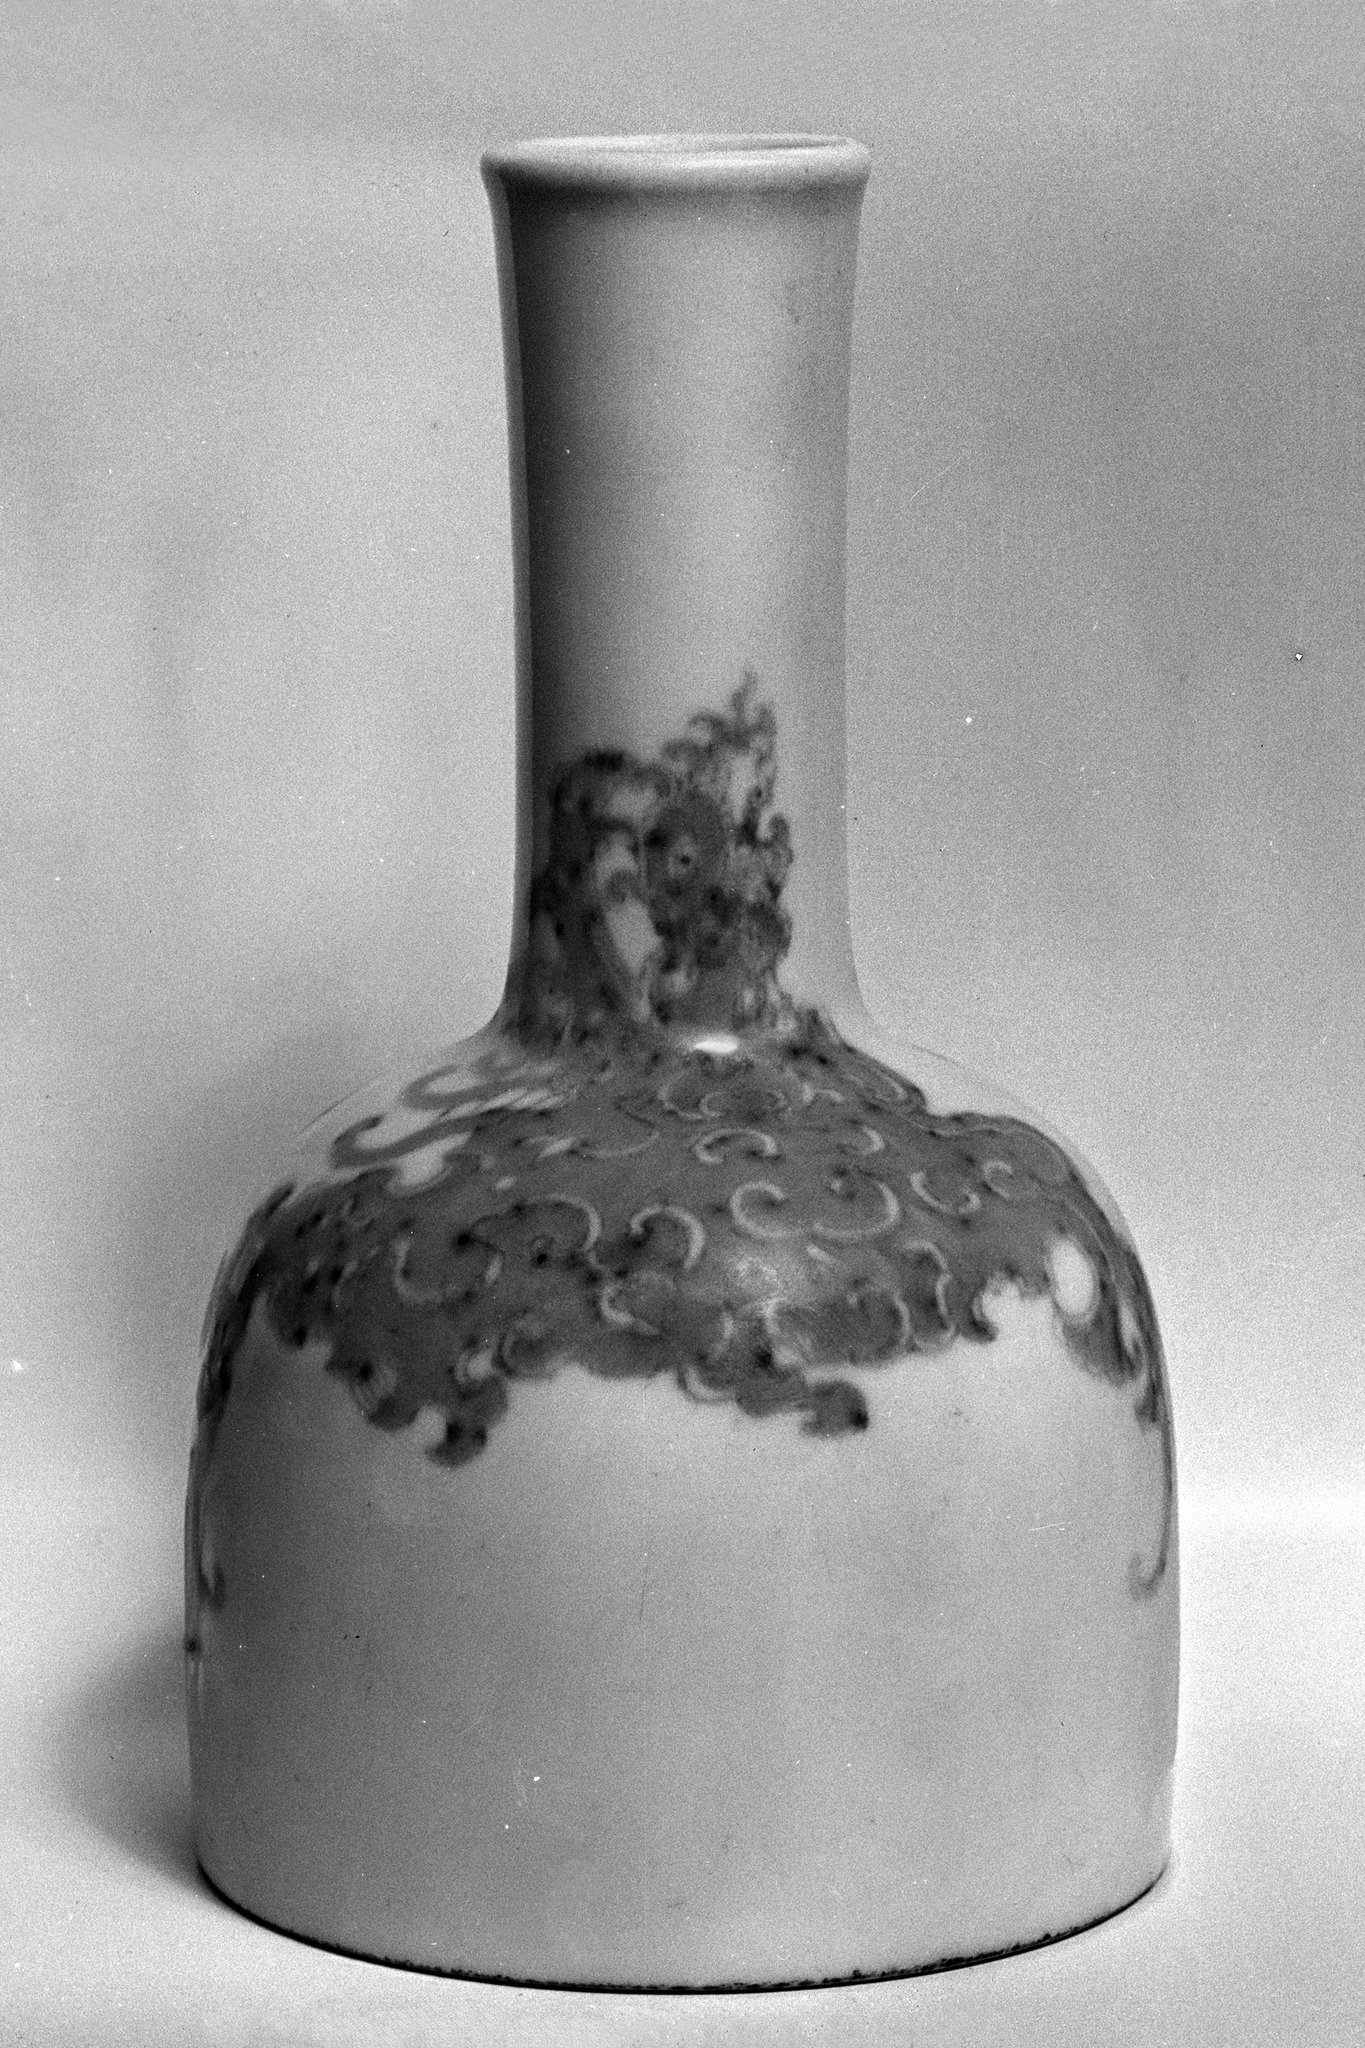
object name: bottle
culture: chinese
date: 1662-1722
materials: copper, glaze, porcelain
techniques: painting, underglaze